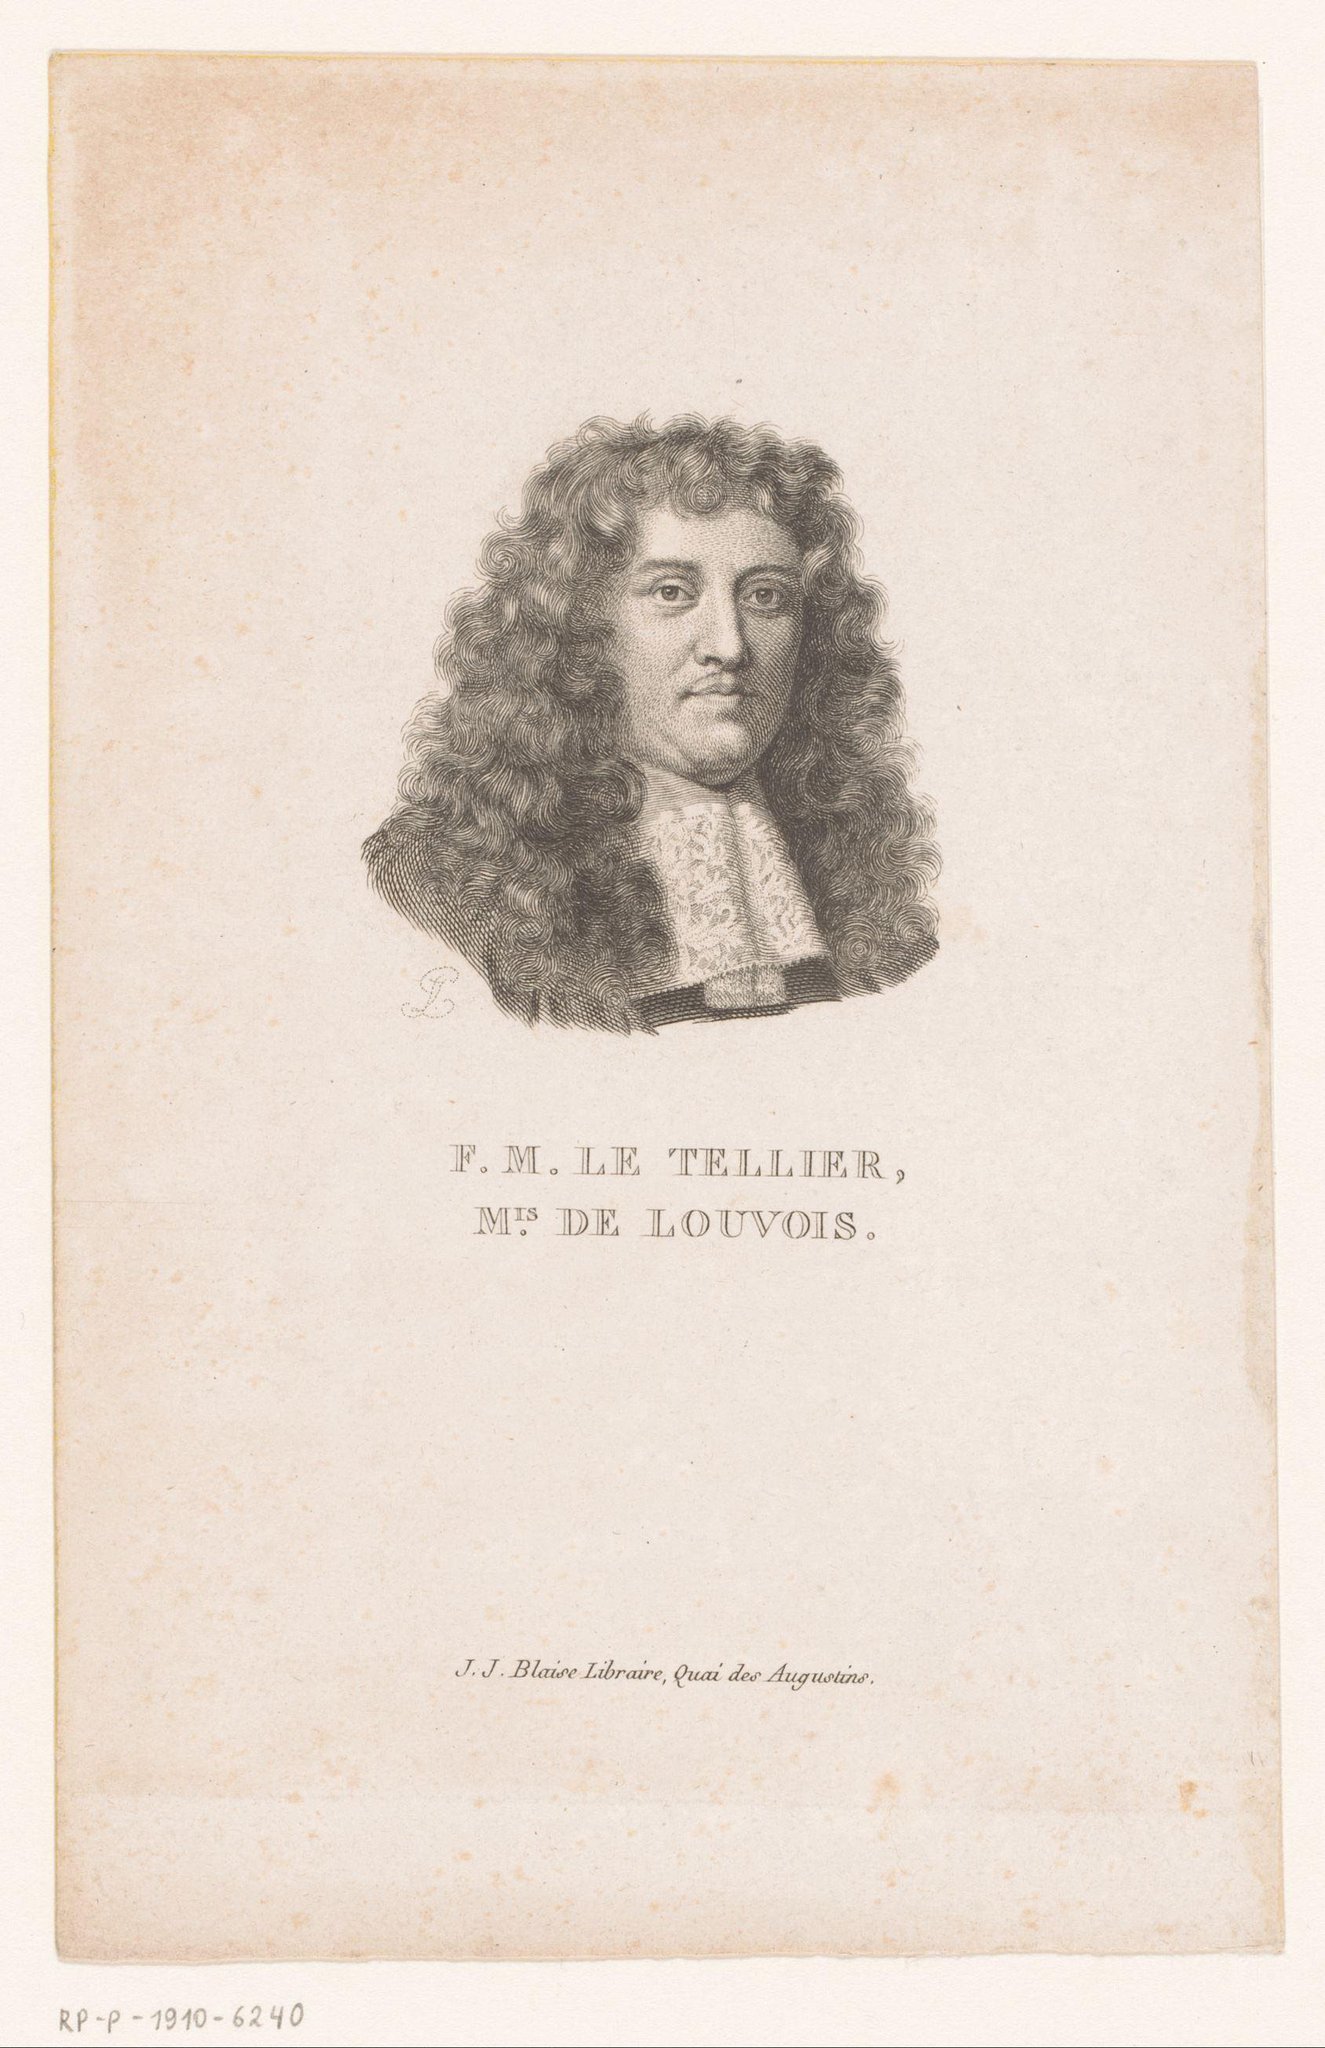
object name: print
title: Portret van Michel le Tellier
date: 1700-1750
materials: paper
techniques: engraving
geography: paris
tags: paris, michel le tellier, historical persons, politician, e.g. party leader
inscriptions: collector's mark: Lugt 2228